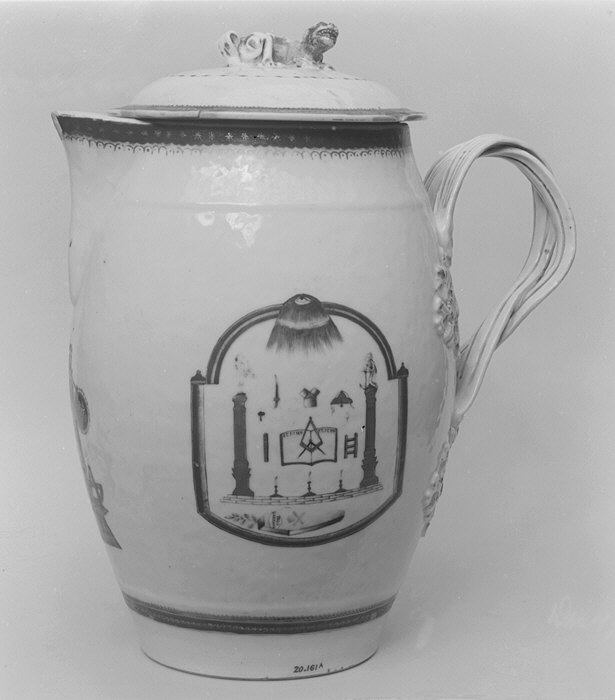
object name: pitcher with cover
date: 1767-1800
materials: hard paste porcelain